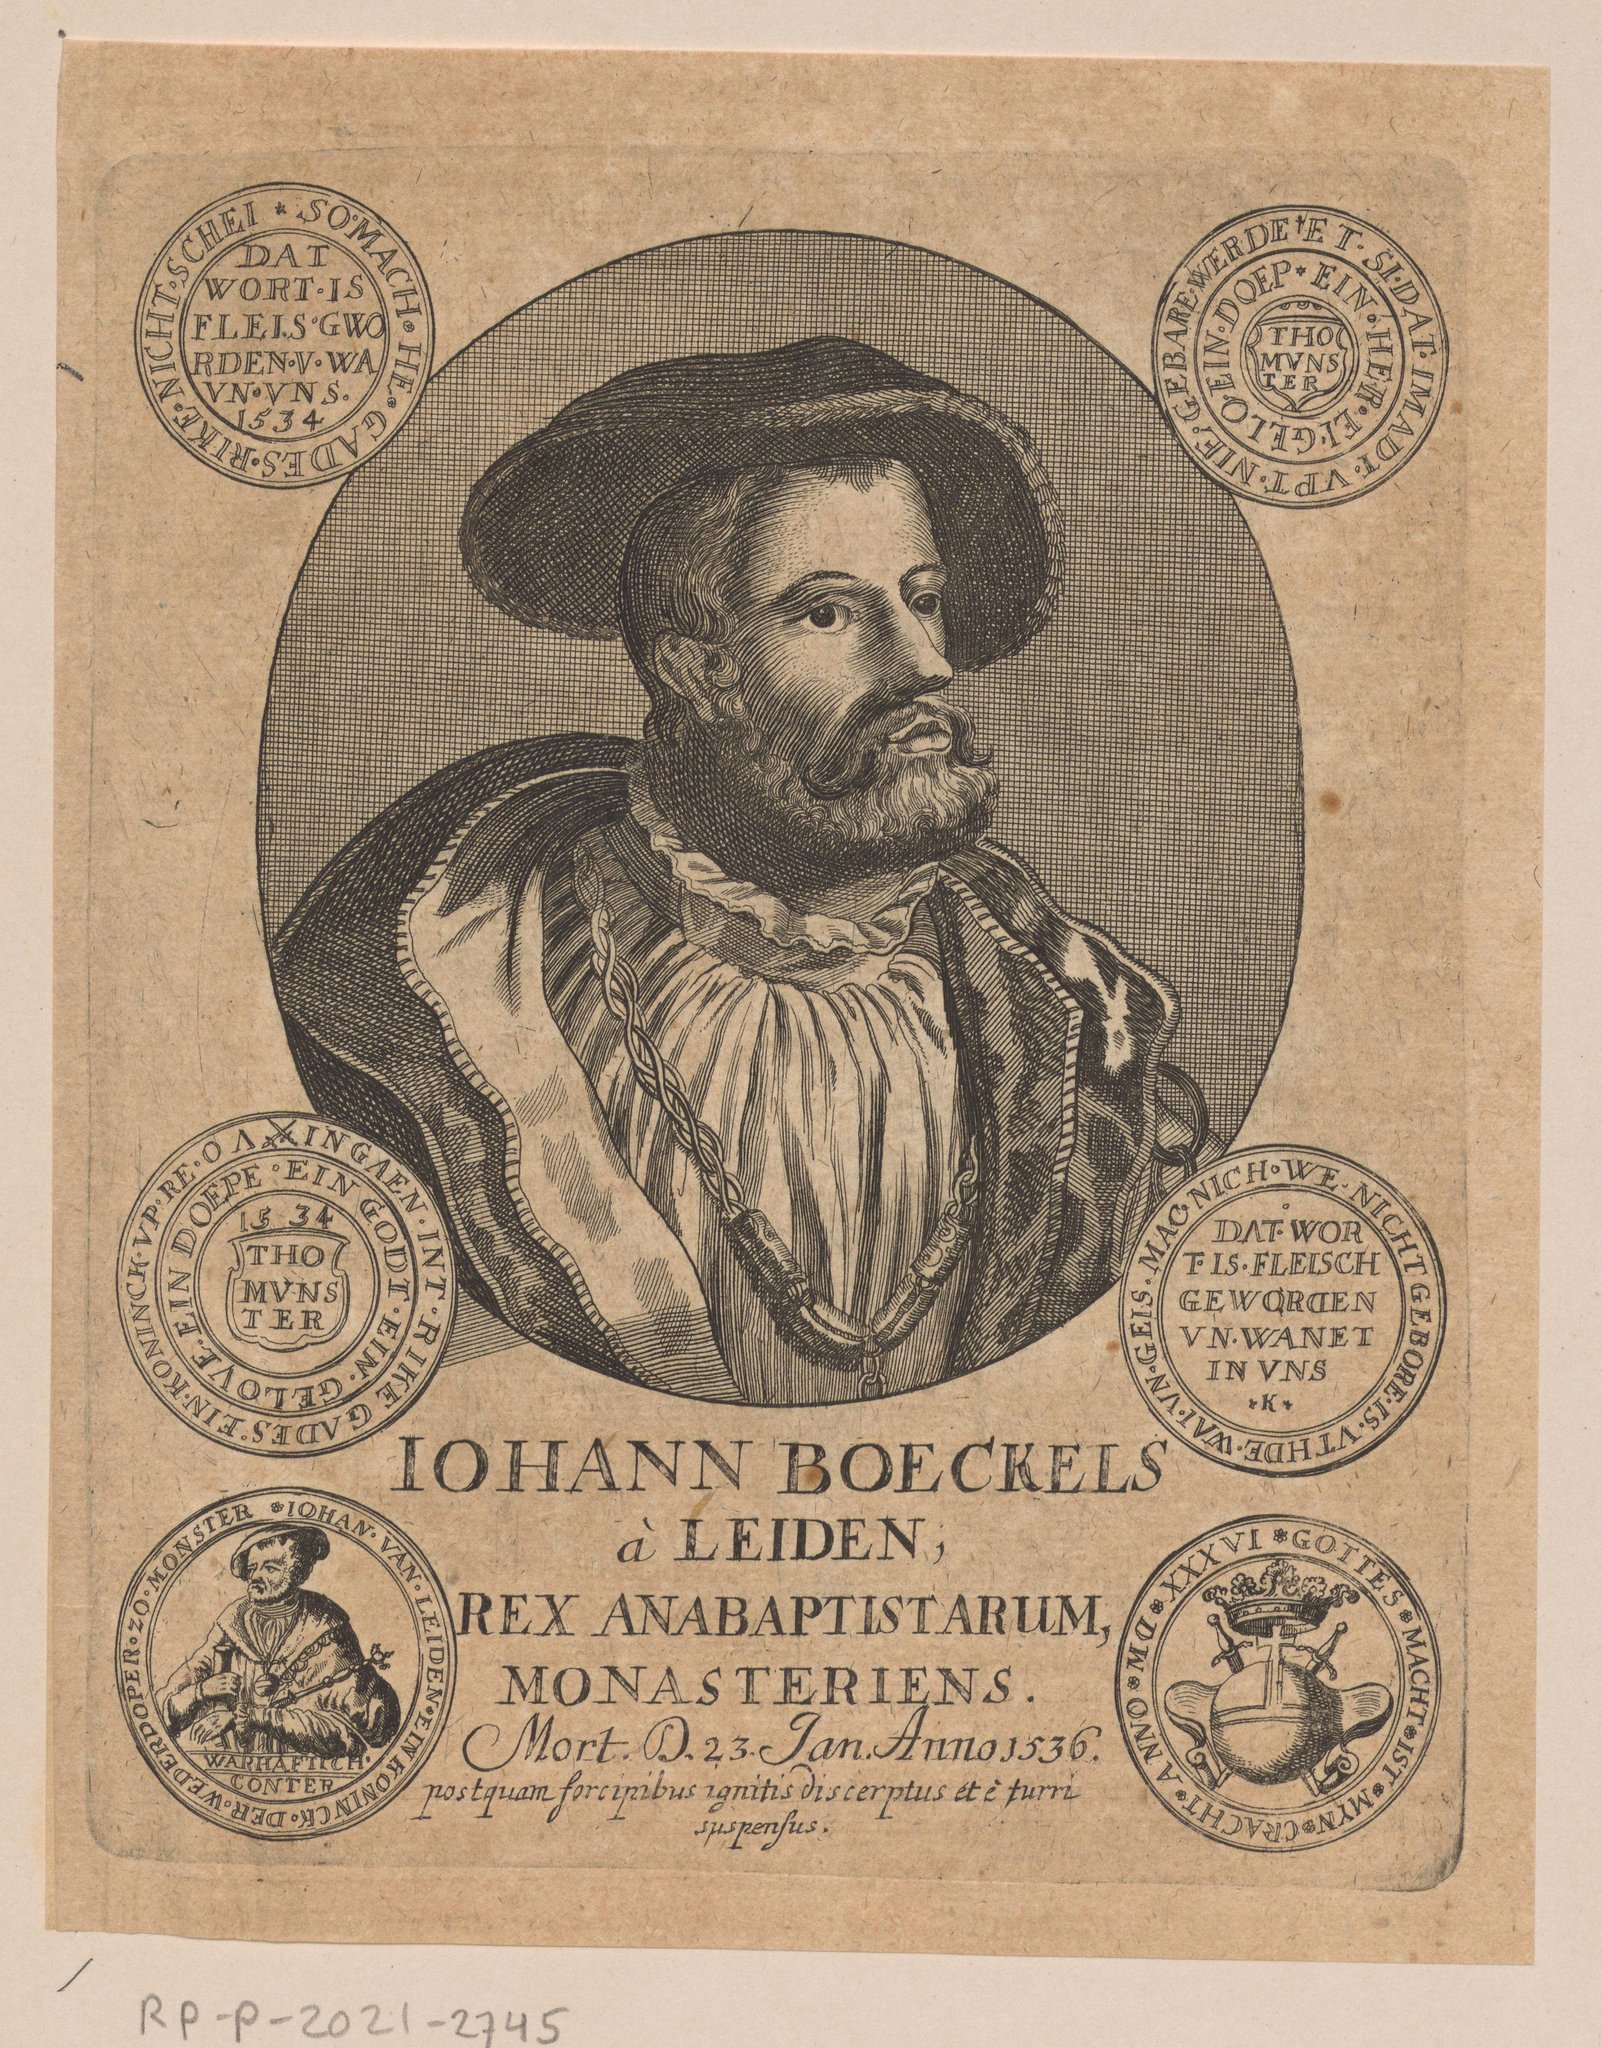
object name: print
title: Portret van Jan van Leiden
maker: Anonymous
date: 1701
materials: paper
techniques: etching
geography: germany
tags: leiden, crown (symbol of sovereignty), orb (symbol of sovereignty; sphere with cross on top), historical persons, coin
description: Prent waarschijnlijk uit: Theobald, Zacharias. Der Alten und Neuen Schwärmer Widertäufferischer Geist (...). Köthen: Wilhelm Andreas Meyer, 1701.